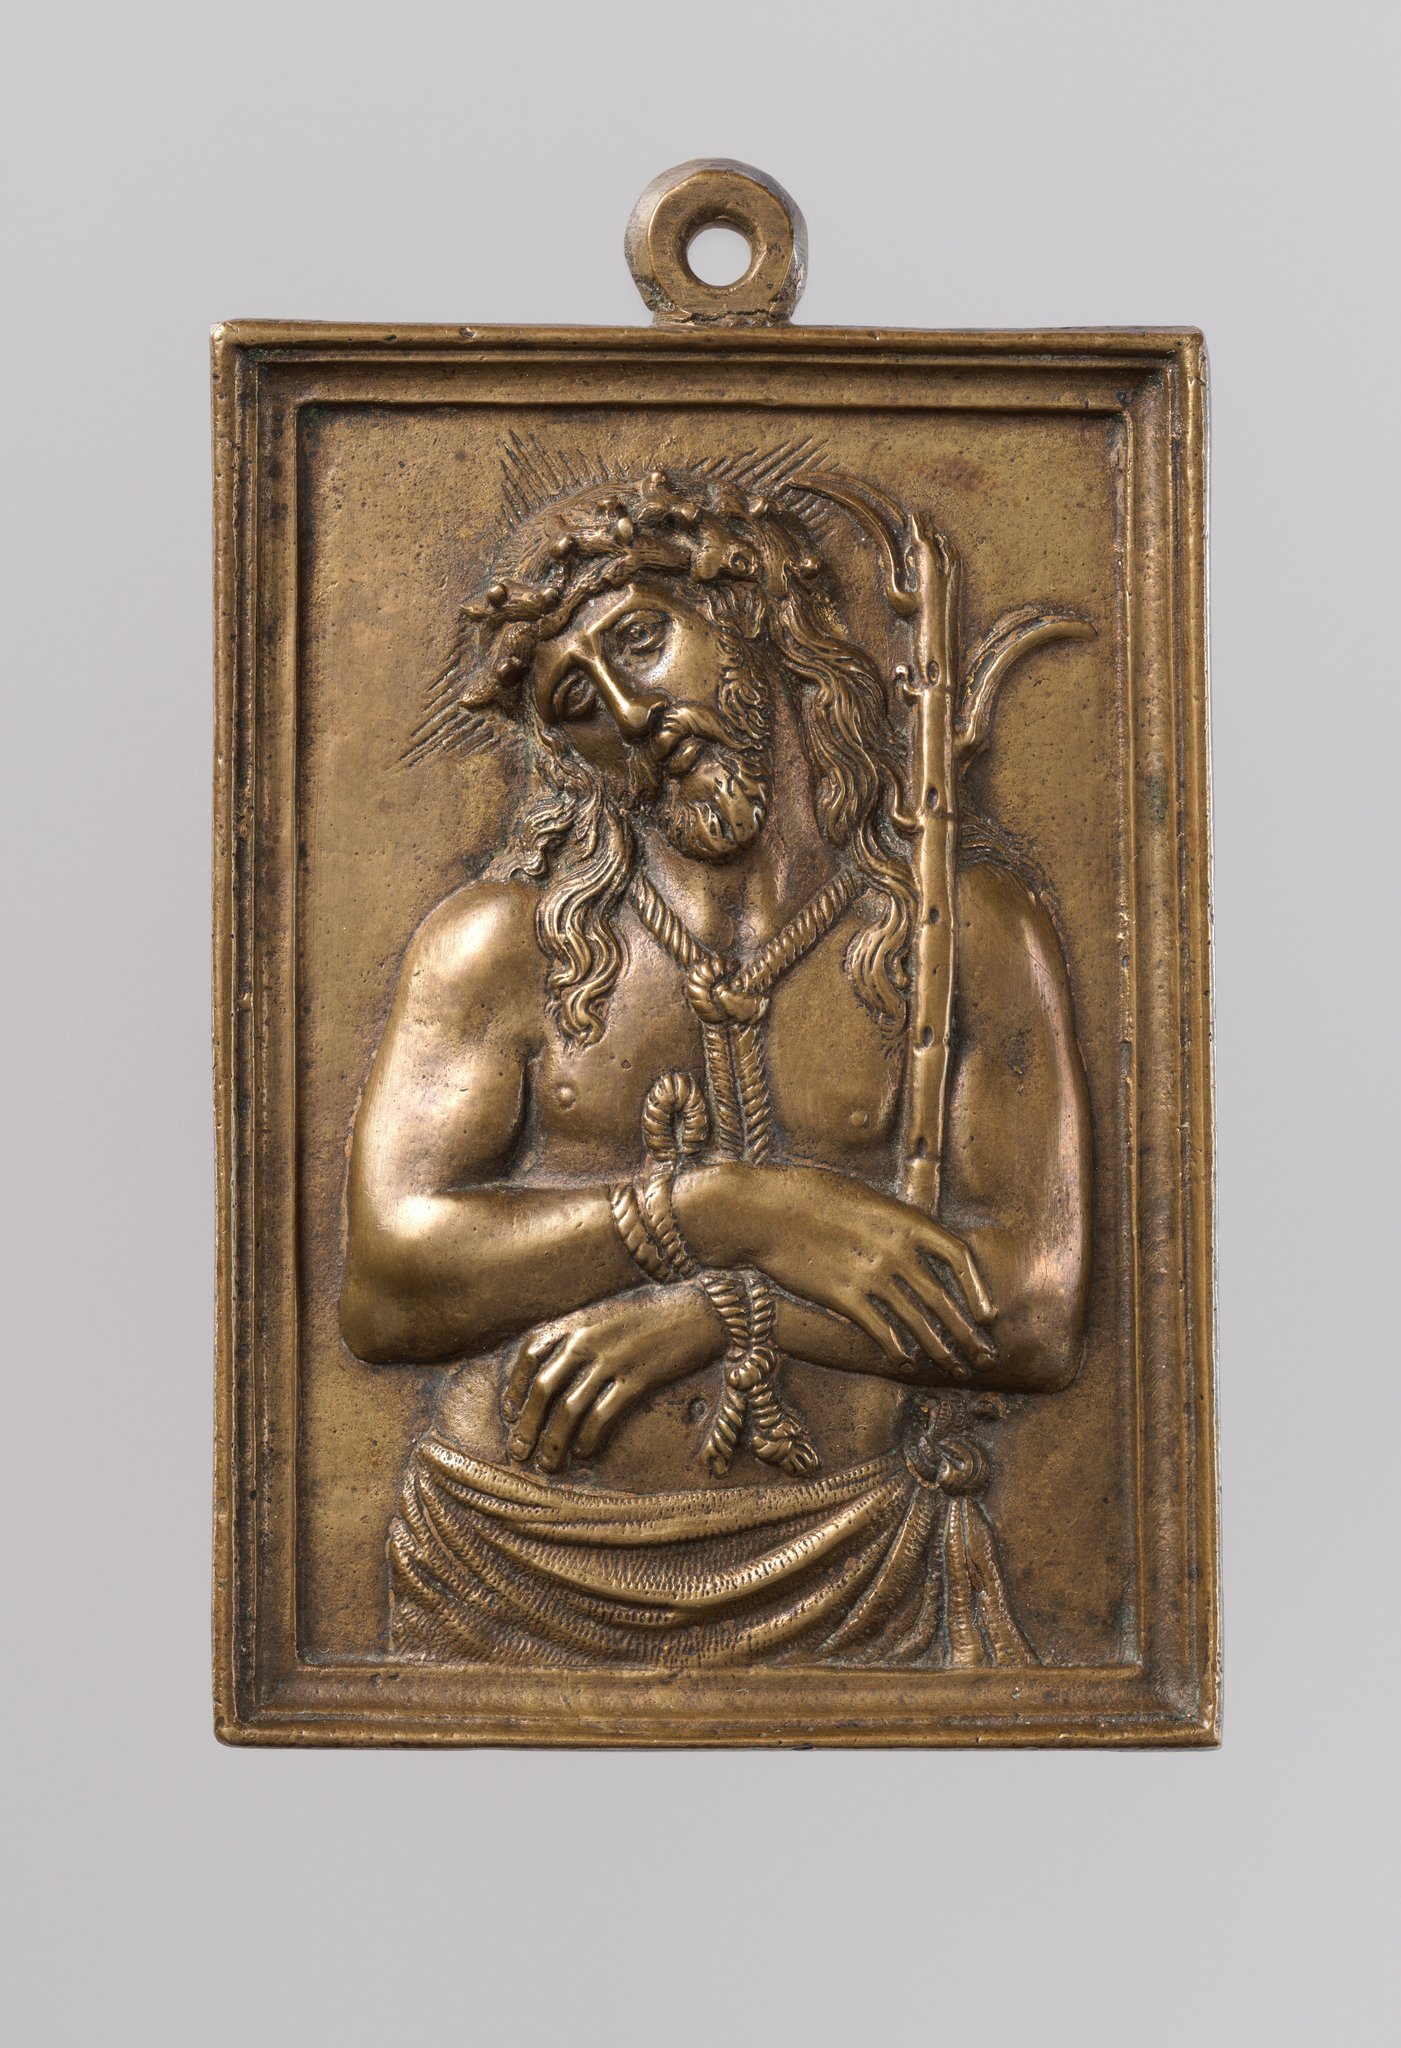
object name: plaquette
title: Ecce Homo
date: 1600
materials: bronze, patina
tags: christ